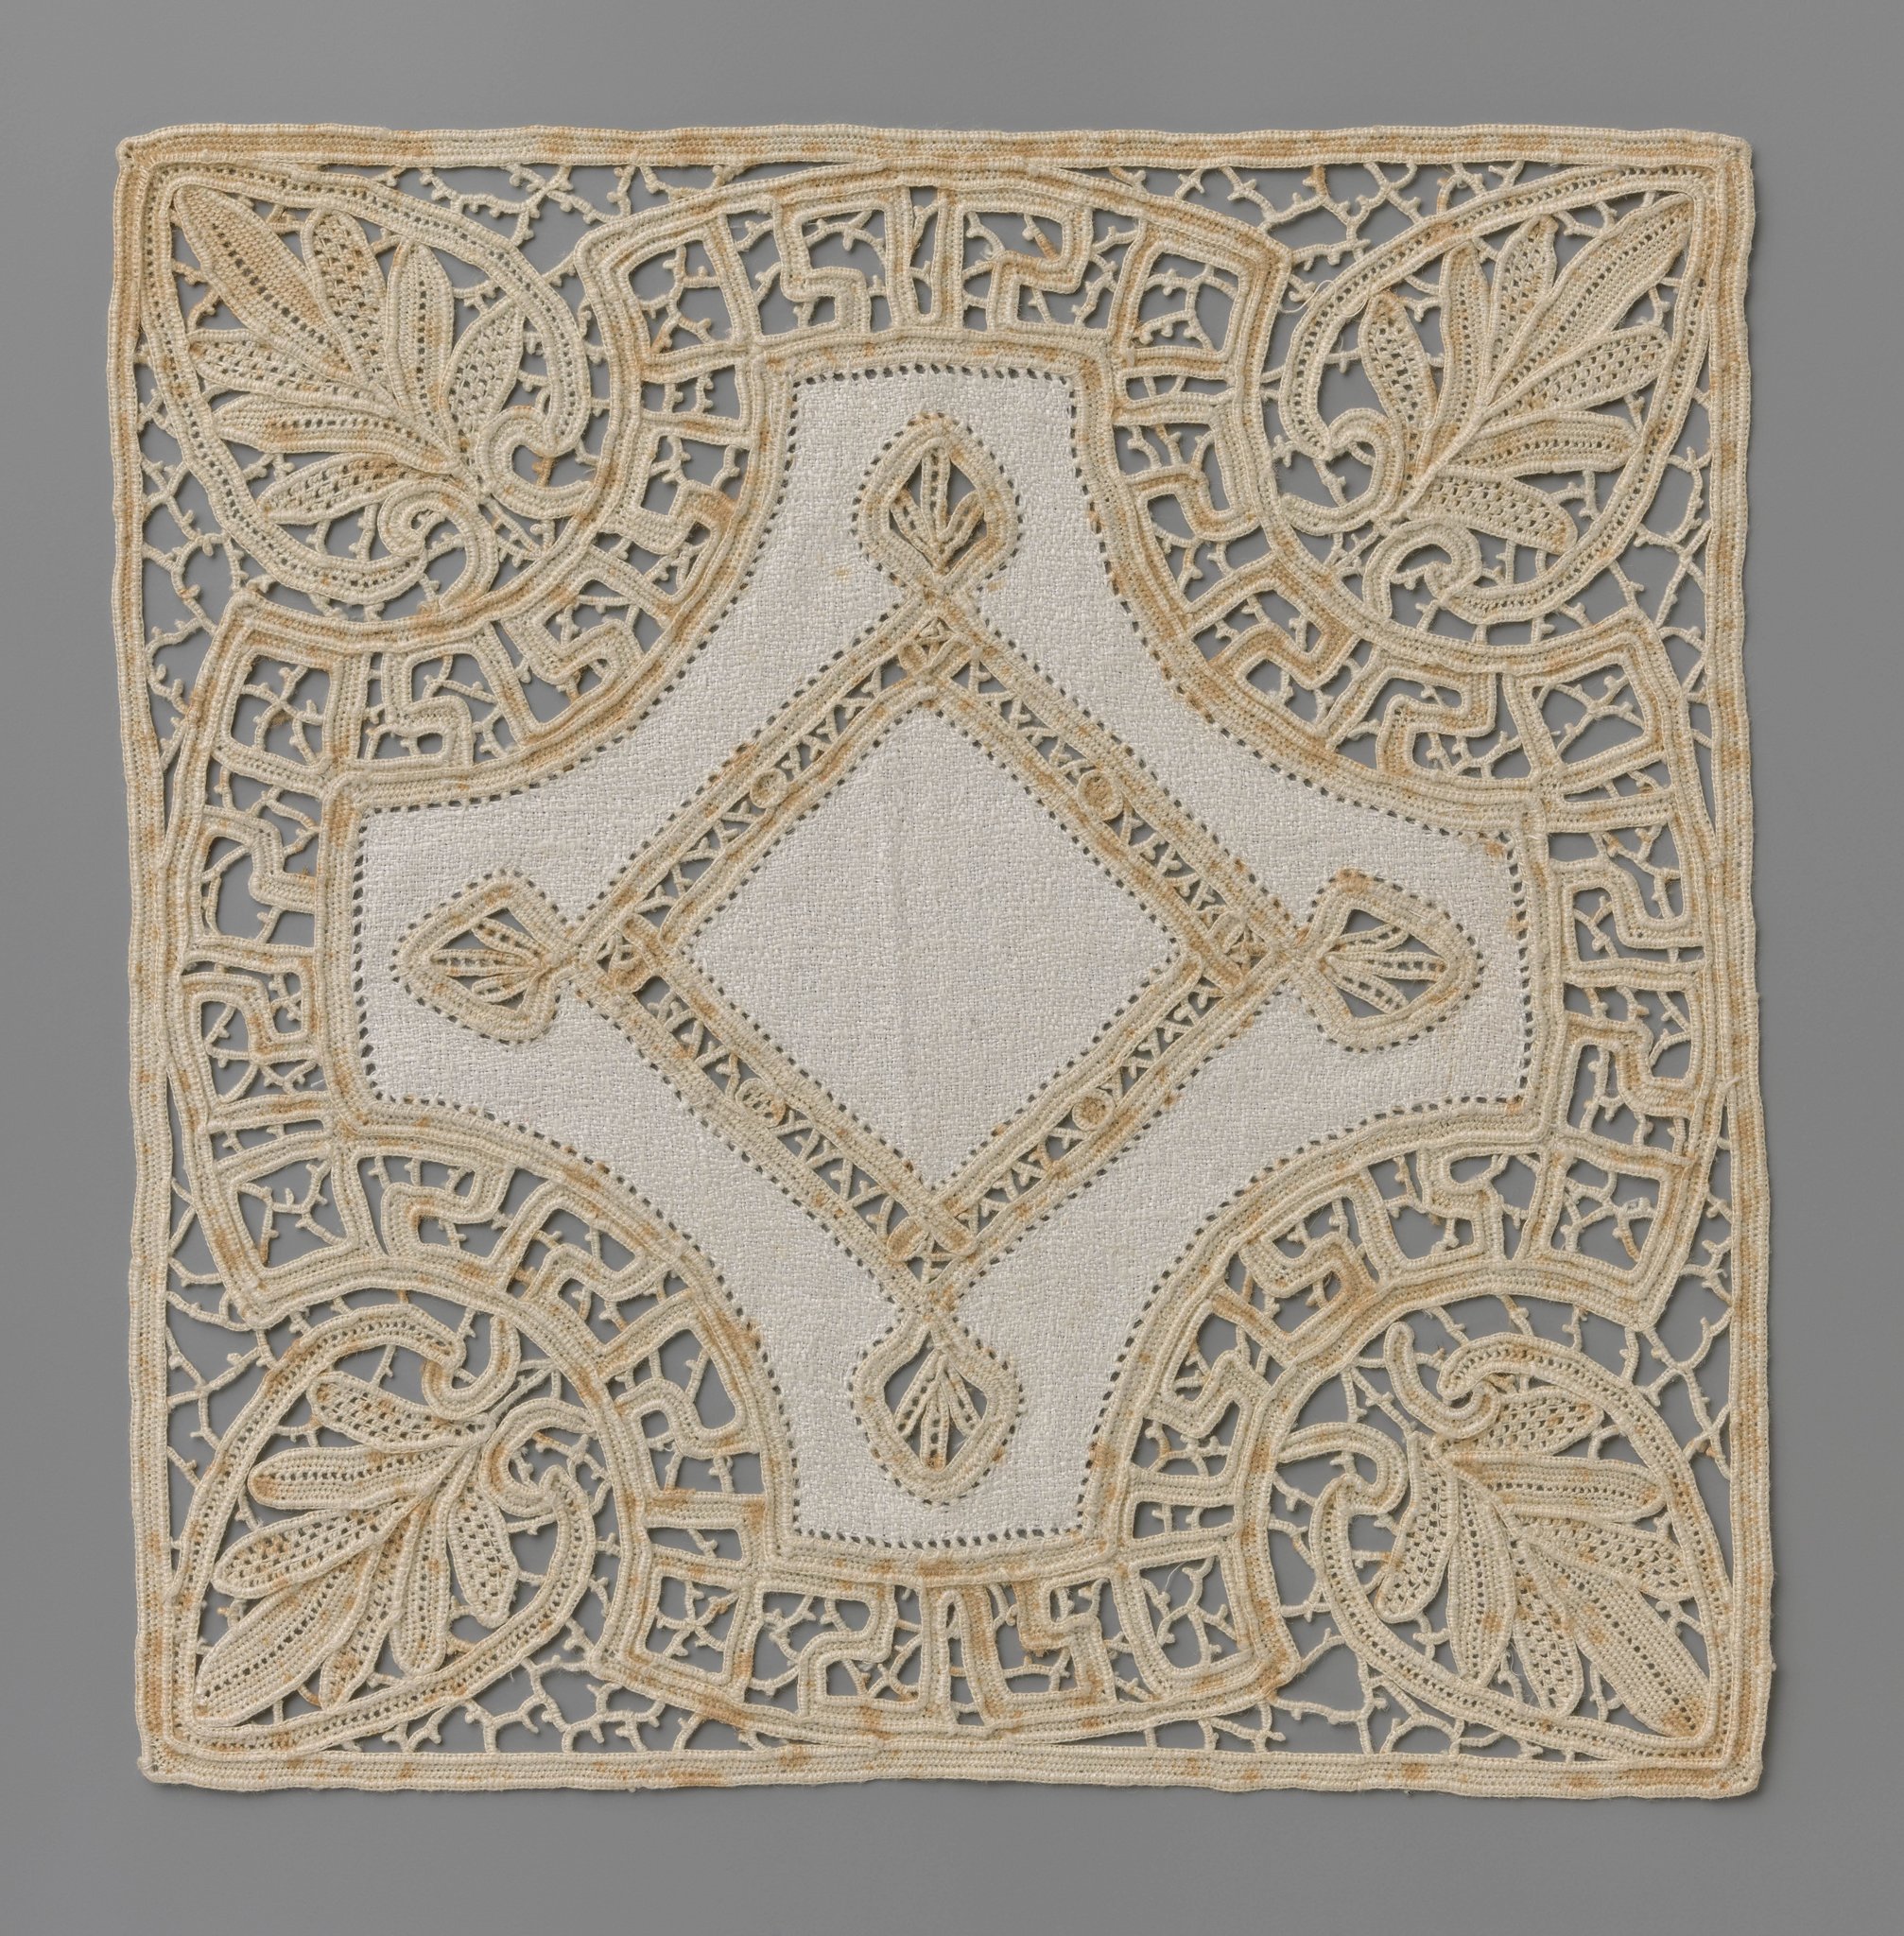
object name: kleed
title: Kleedje van naaldkant met palmetten en geweven ruit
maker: Anonymous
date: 1900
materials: linen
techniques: embroidery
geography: italy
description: Kleedje van naturelkleurige naaldkant: Venetiaanse reliëfkant. Vierkant model met een vierzijdig, hol geschulpt linnen middenstuk. In het centrum van het linnen is een kanten ruit gezet. Om het linnen heen loopt een rand die is opgebouwd uit een binnenlijst met gebroken meanders. Het hoekmotief is voor elke hoek gelijk en bestaat uit een druppelvormig cartouche met daarin een palmet.